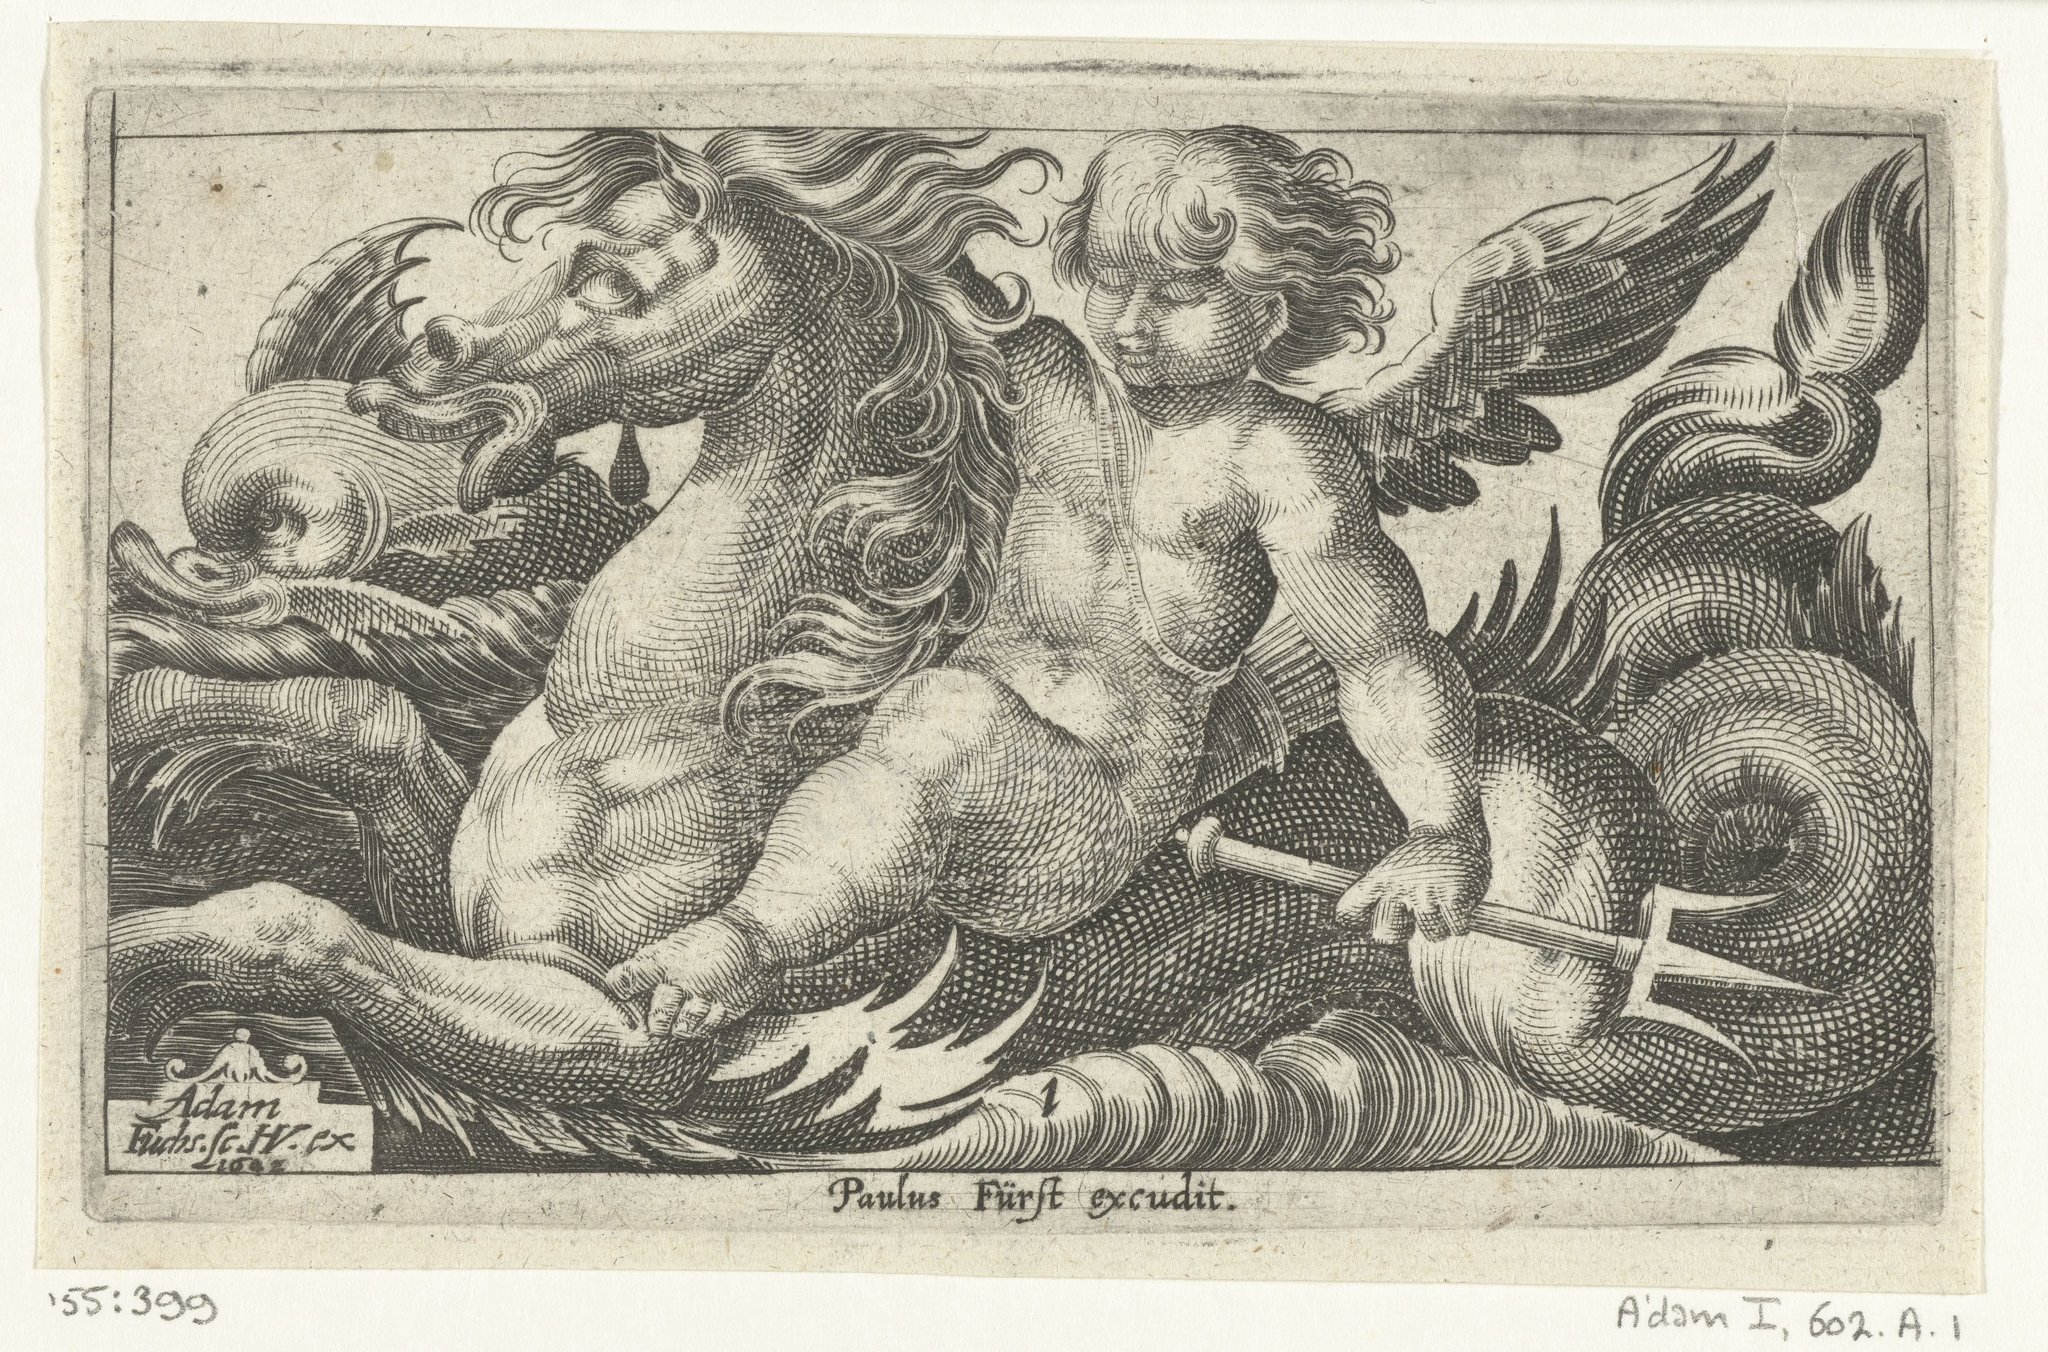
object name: print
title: Putto met een drietand, rijdend op een zeepaard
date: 1605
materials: paper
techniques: engraving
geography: germany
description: Tegenzijdige kopie naar een prent van Giovanni Andrea Maglioli.